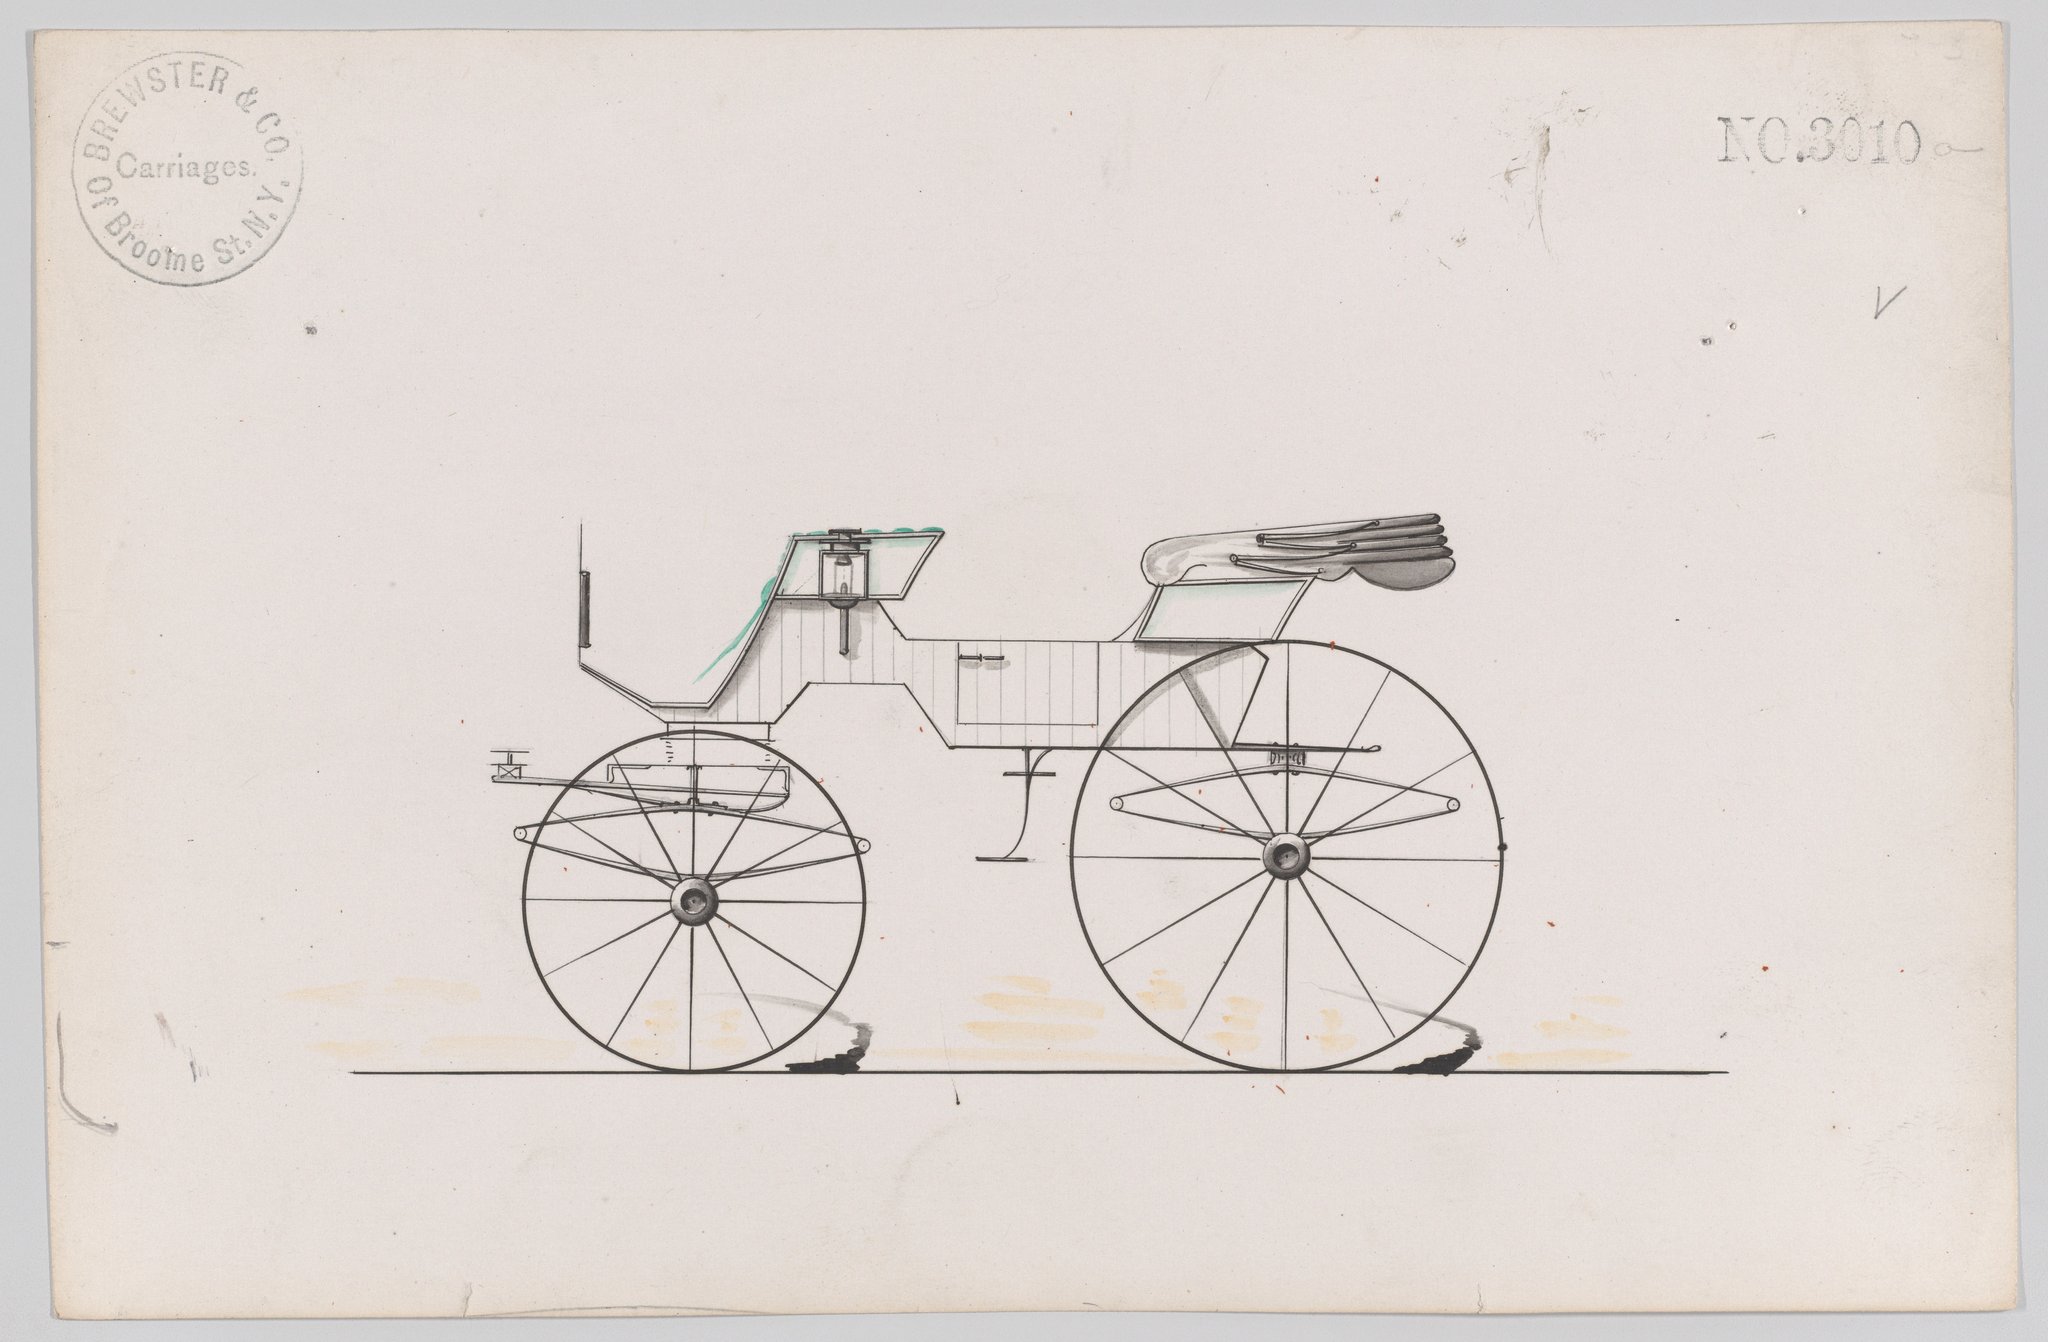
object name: drawing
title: Design for 2 seat Phaeton, no. 3010a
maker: brewster & co.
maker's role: manufacturer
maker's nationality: american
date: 1874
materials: gouache, ink, watercolor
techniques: pen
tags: carriages